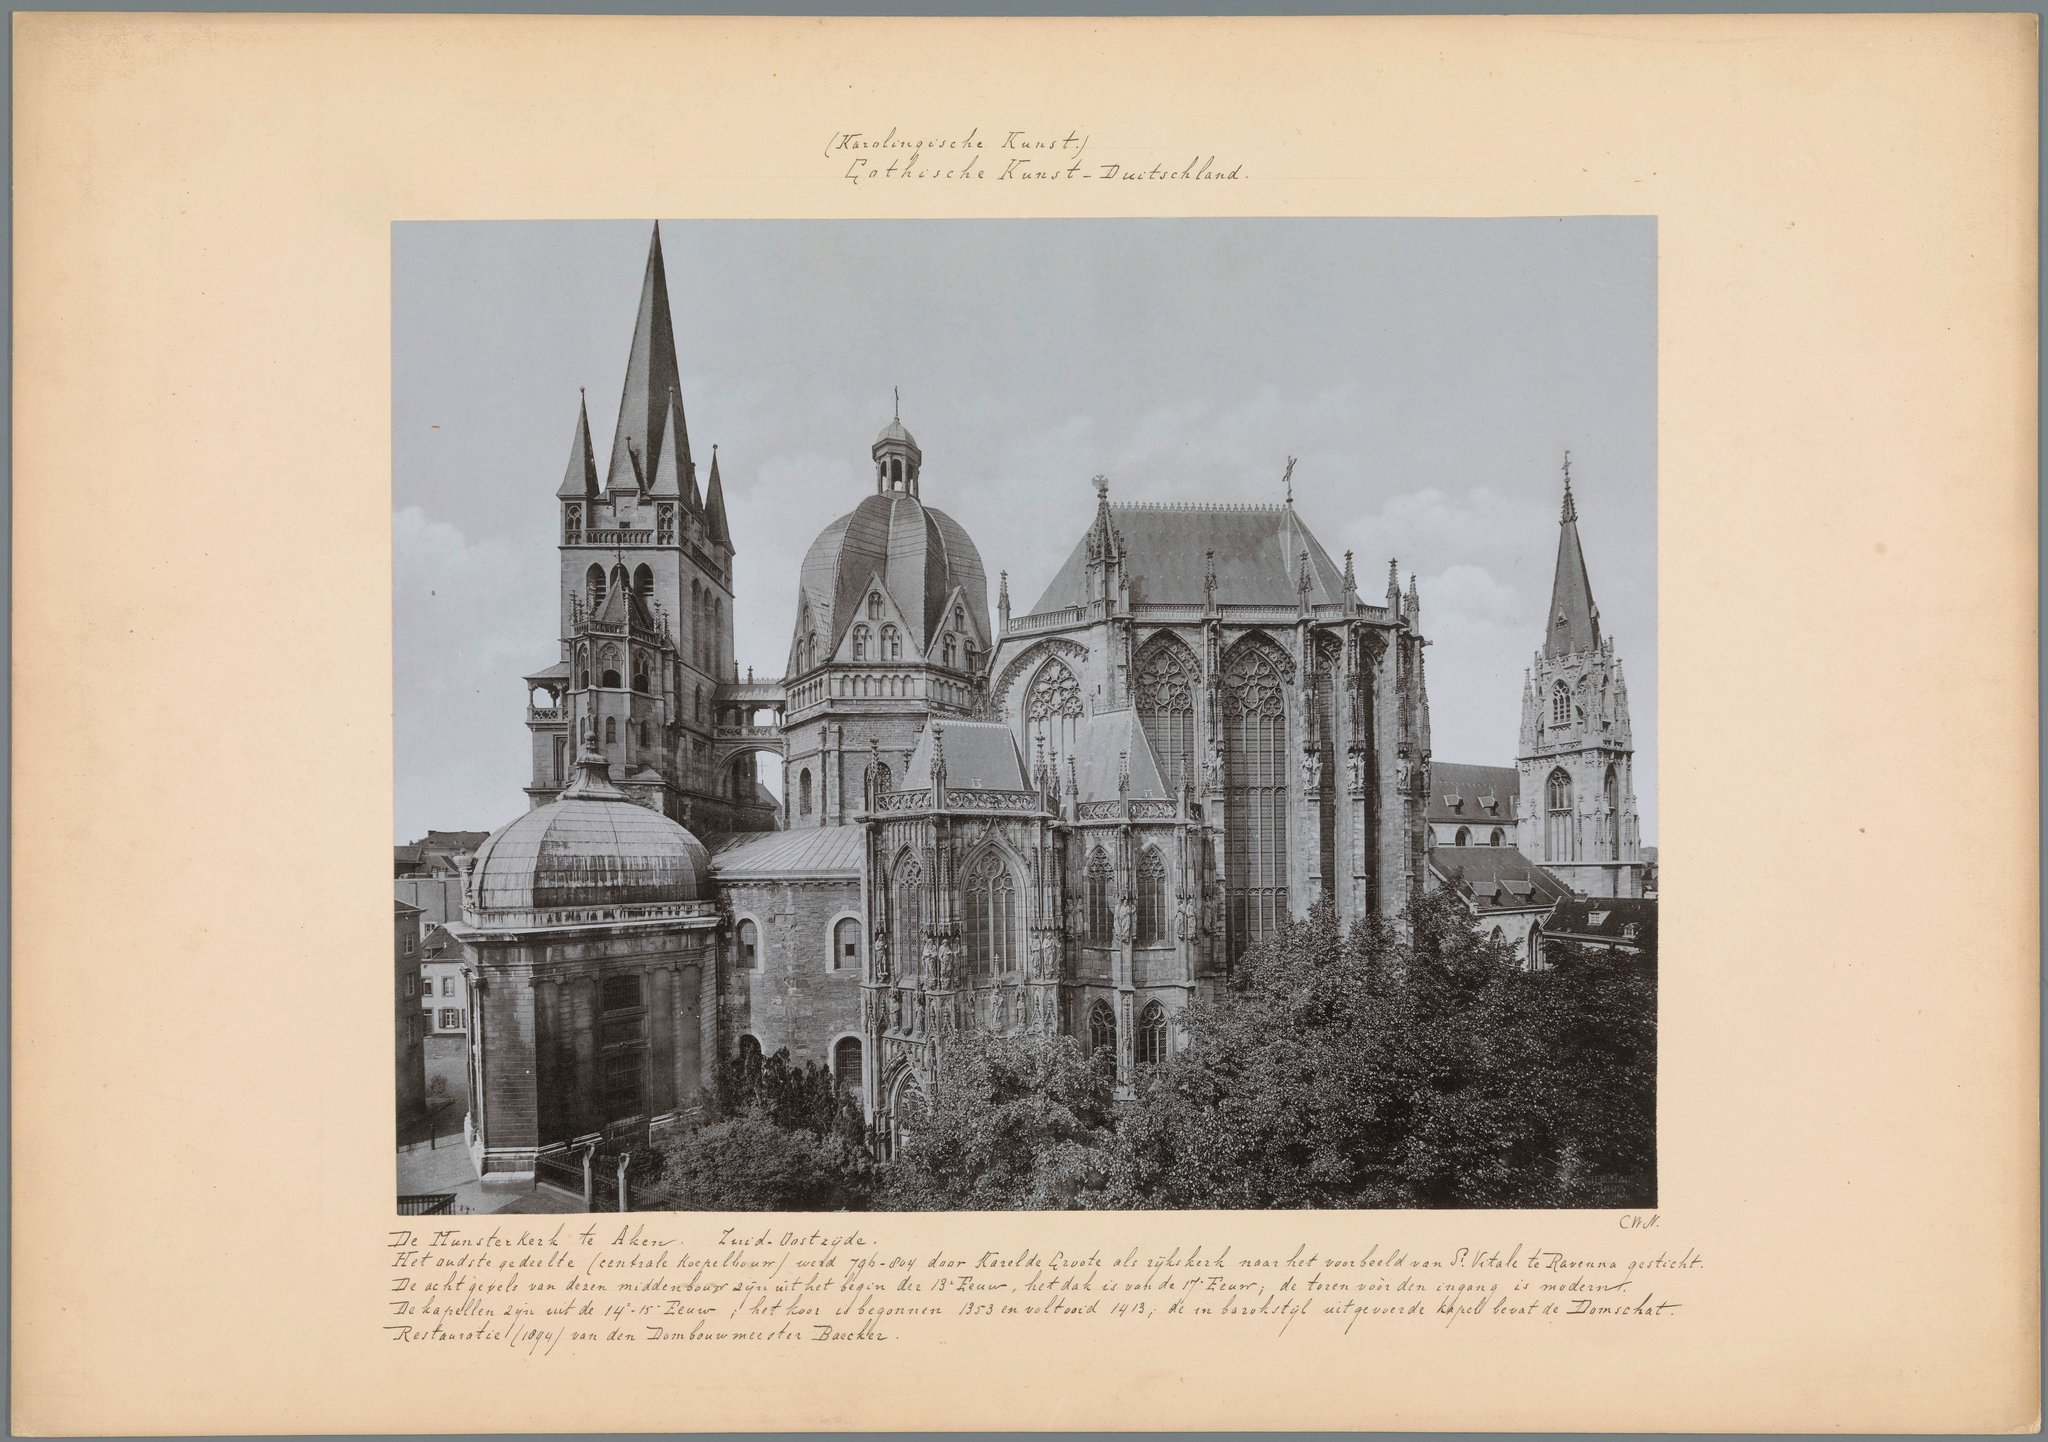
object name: photograph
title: De Munsterkerek te Aken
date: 1897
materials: cardboard, paper, ink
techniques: photograph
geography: aachen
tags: tower, clock tower ~ monumental adornment, church (exterior)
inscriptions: inscription: ‘CWN.’, collector's mark: ‘INSTITUUT VOOR KUNST-NIJVERHEIDSONDERWIJS GABRIËL METSUSTRAAT No. 16 AMSTERDAM’, collector's mark: ‘KUNSTNIJVERHEIDSCHOOL QUELLINUS AMSTERDAM FRANS HALSSTRAAT 14.’, name: ‘STENGEL&CO 1897 DRESDEN.’, inscription: ‘Gothische Kunst (Karolingische Kunst.) - Duitschland.’